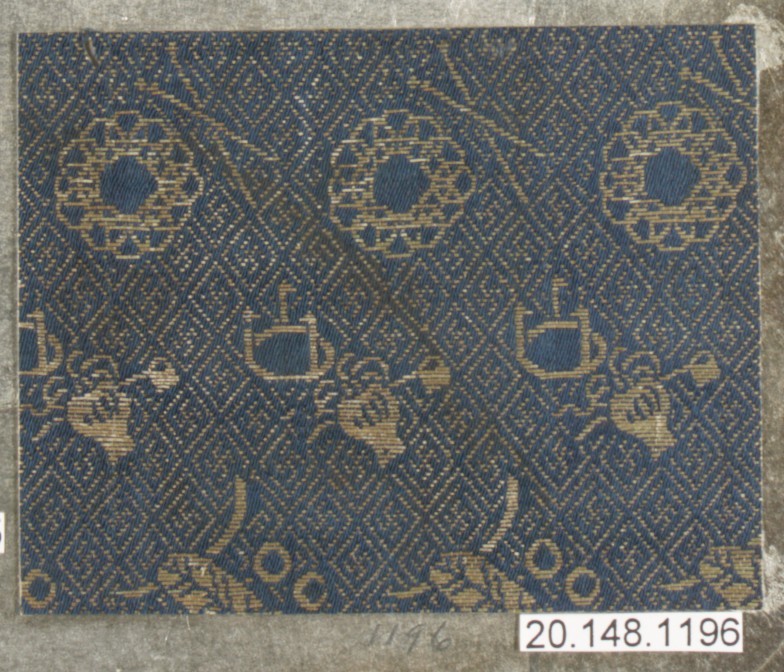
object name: piece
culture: japanese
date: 1701-1800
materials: silk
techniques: compound weave